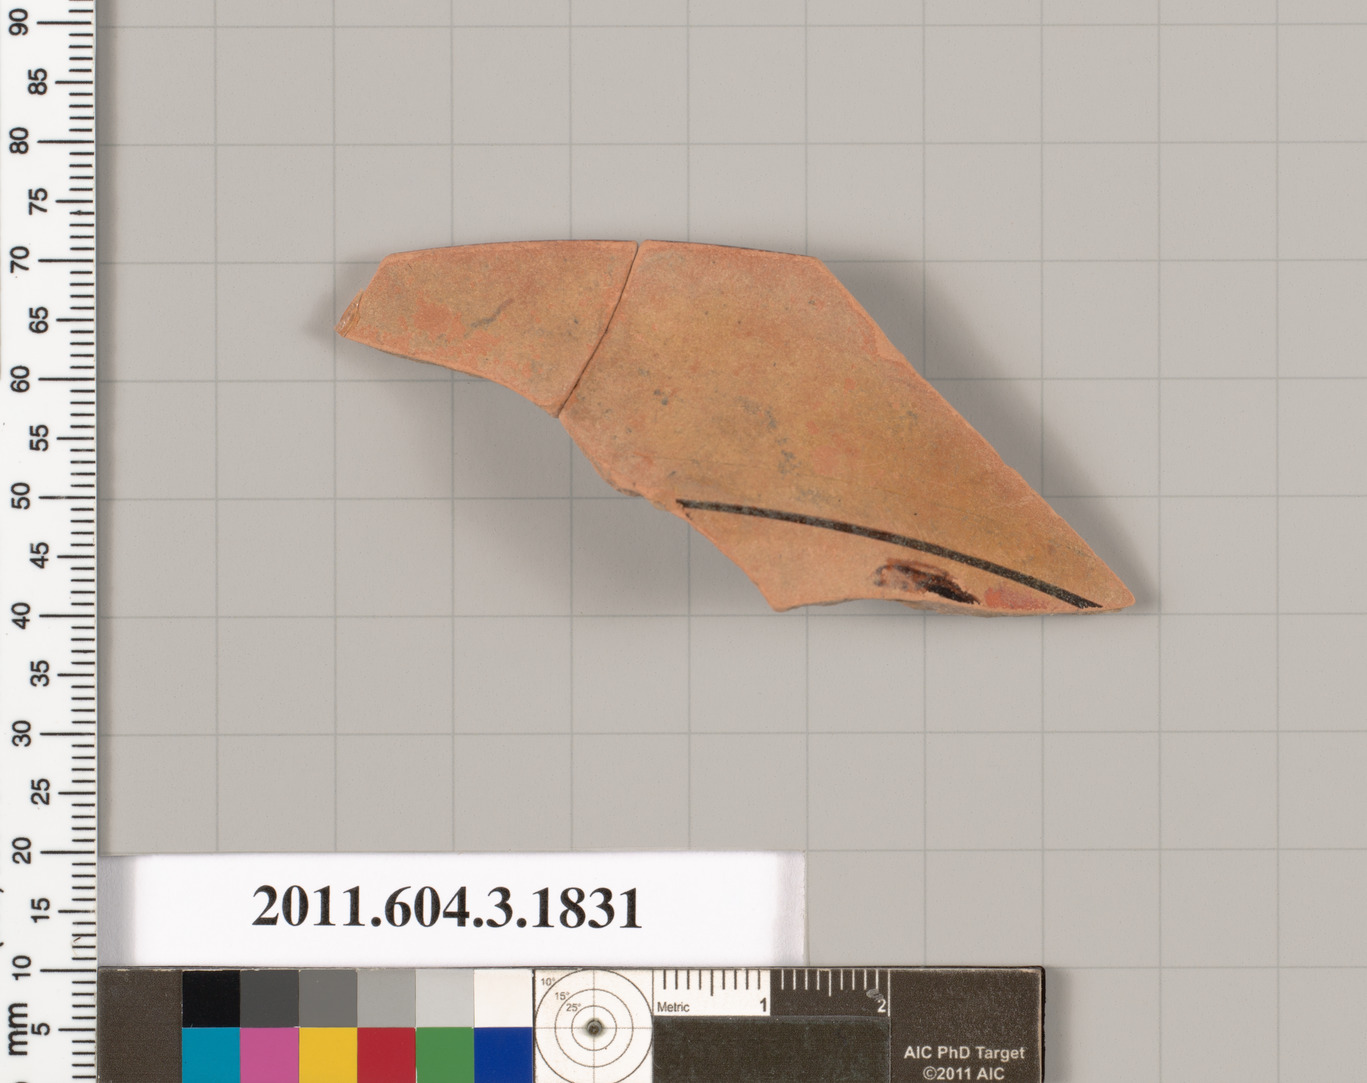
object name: kylix fragment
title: Terracotta fragment of a kylix: Lip cup (drinking cup)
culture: greek, attic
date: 560-525 BCE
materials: terracotta